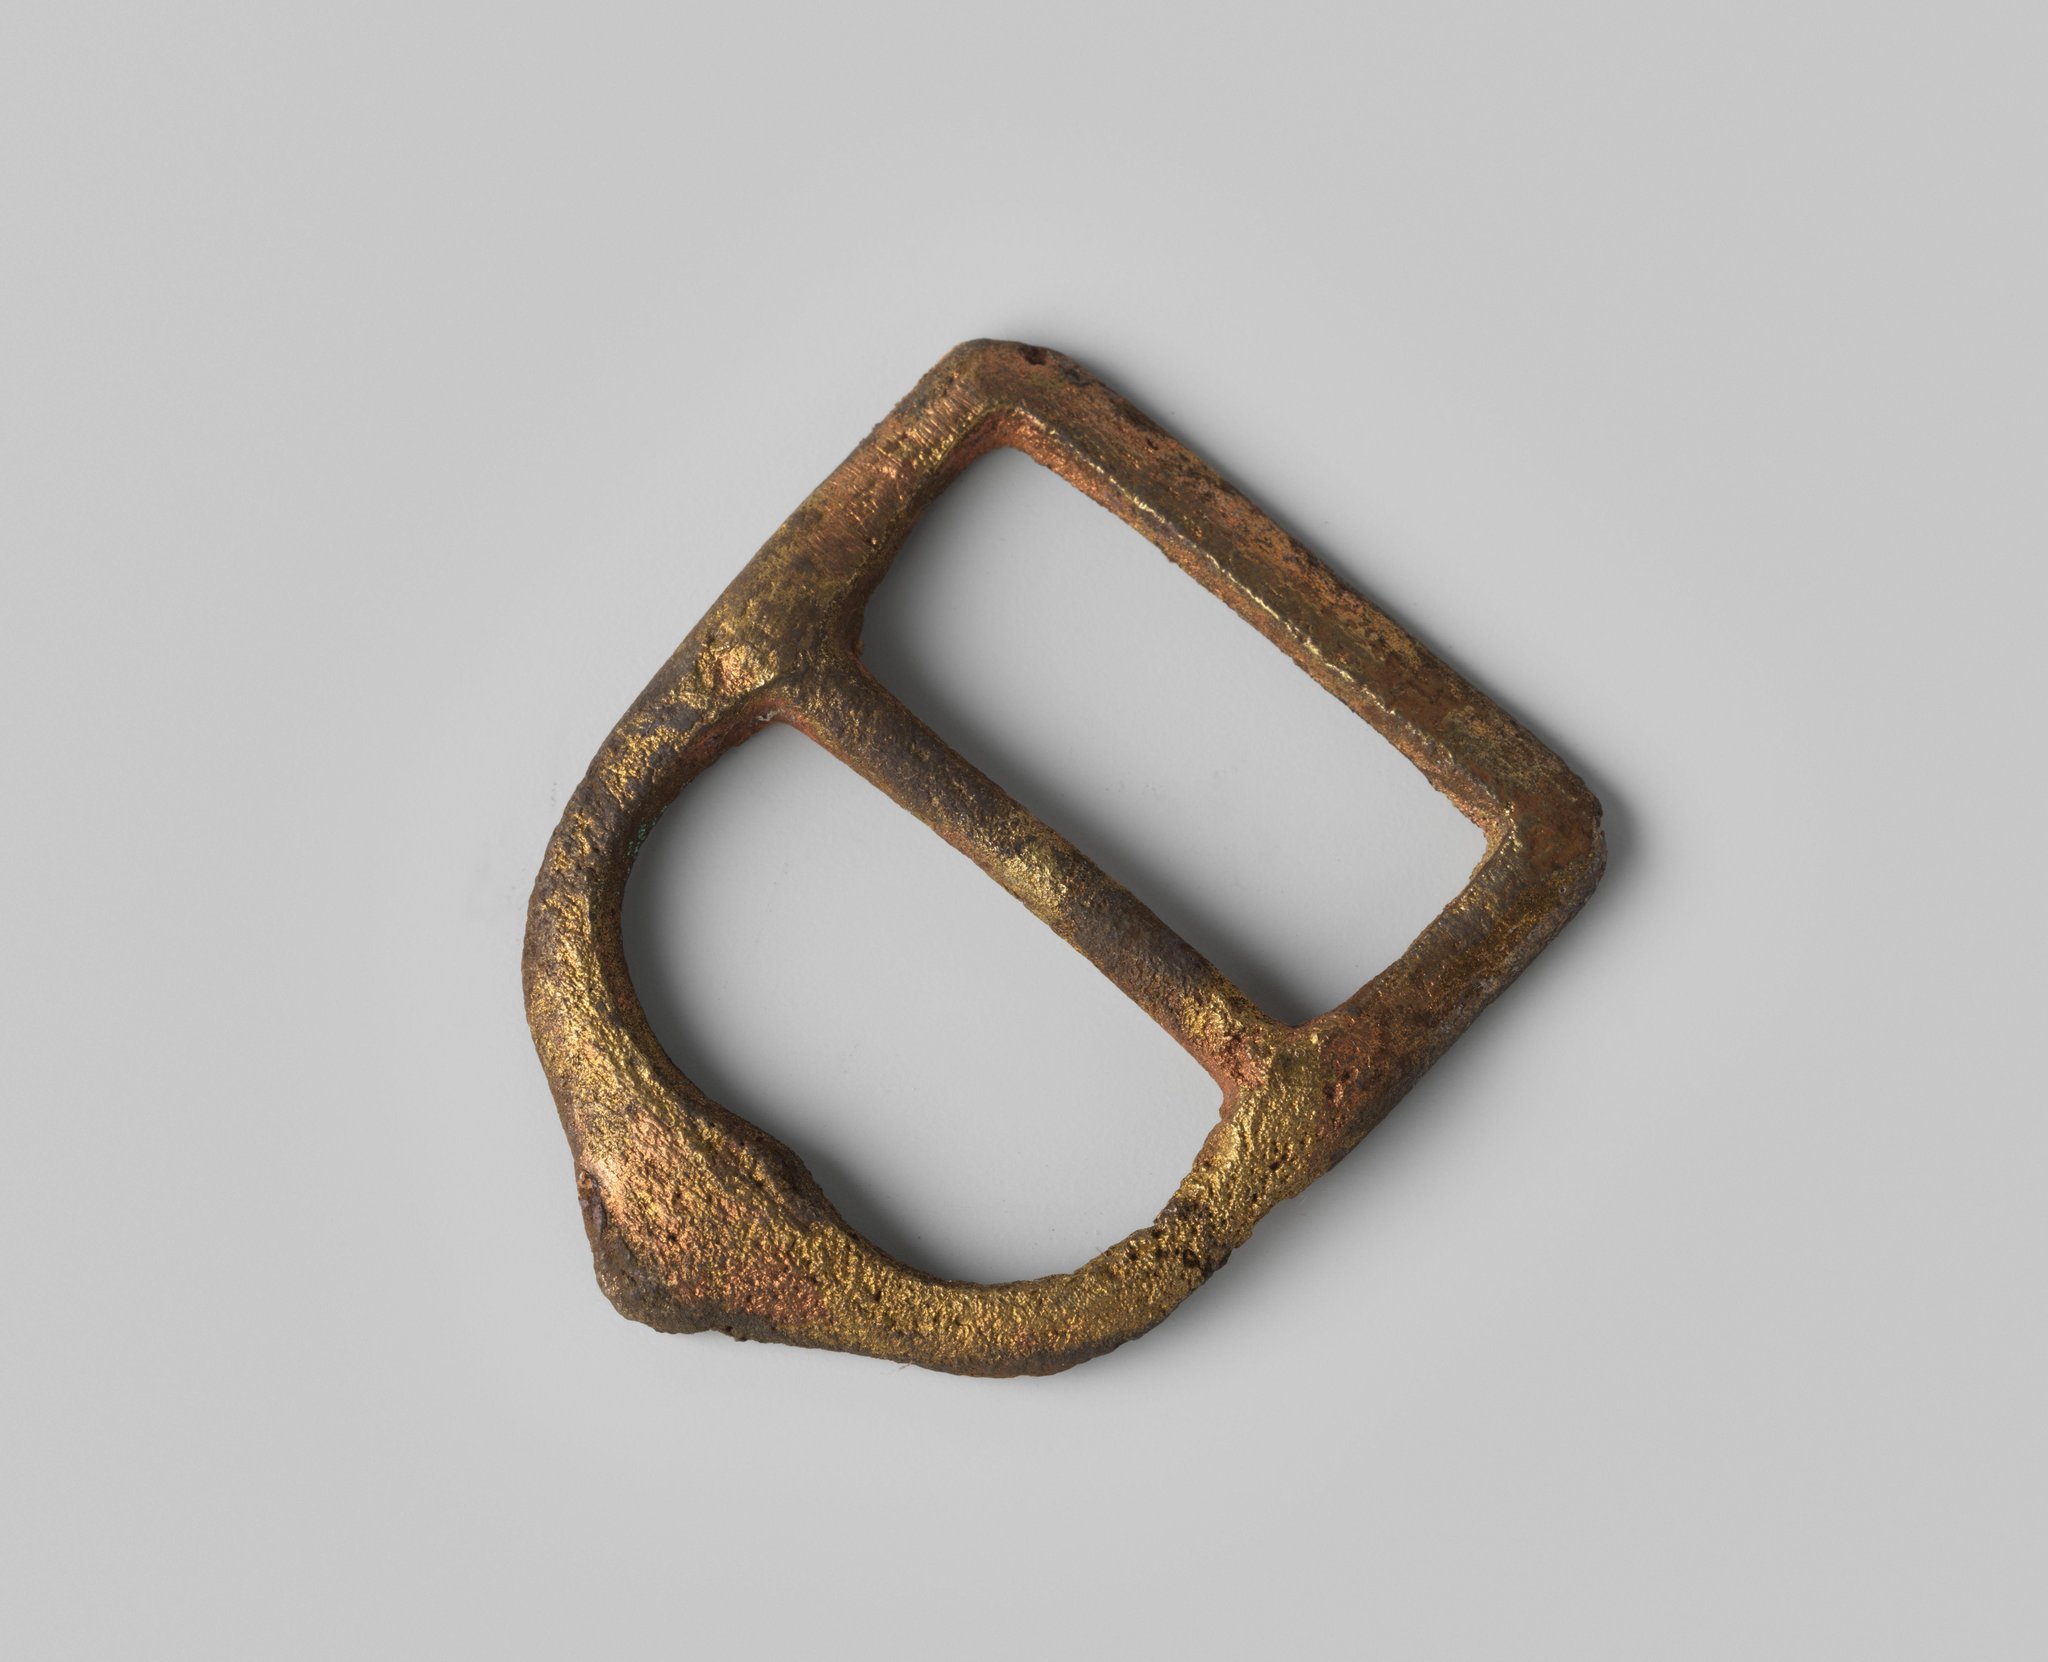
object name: belt buckle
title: Riemgesp uit het wrak van de Oost-Indiëvaarder Hollandia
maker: Anonymous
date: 1700-1743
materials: copper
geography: netherlands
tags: verenigde oostindische compagnie, hollandia (schip), annet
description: D-shaped with pointed side, ring, id. NG 1980-27H384, belt buckle.